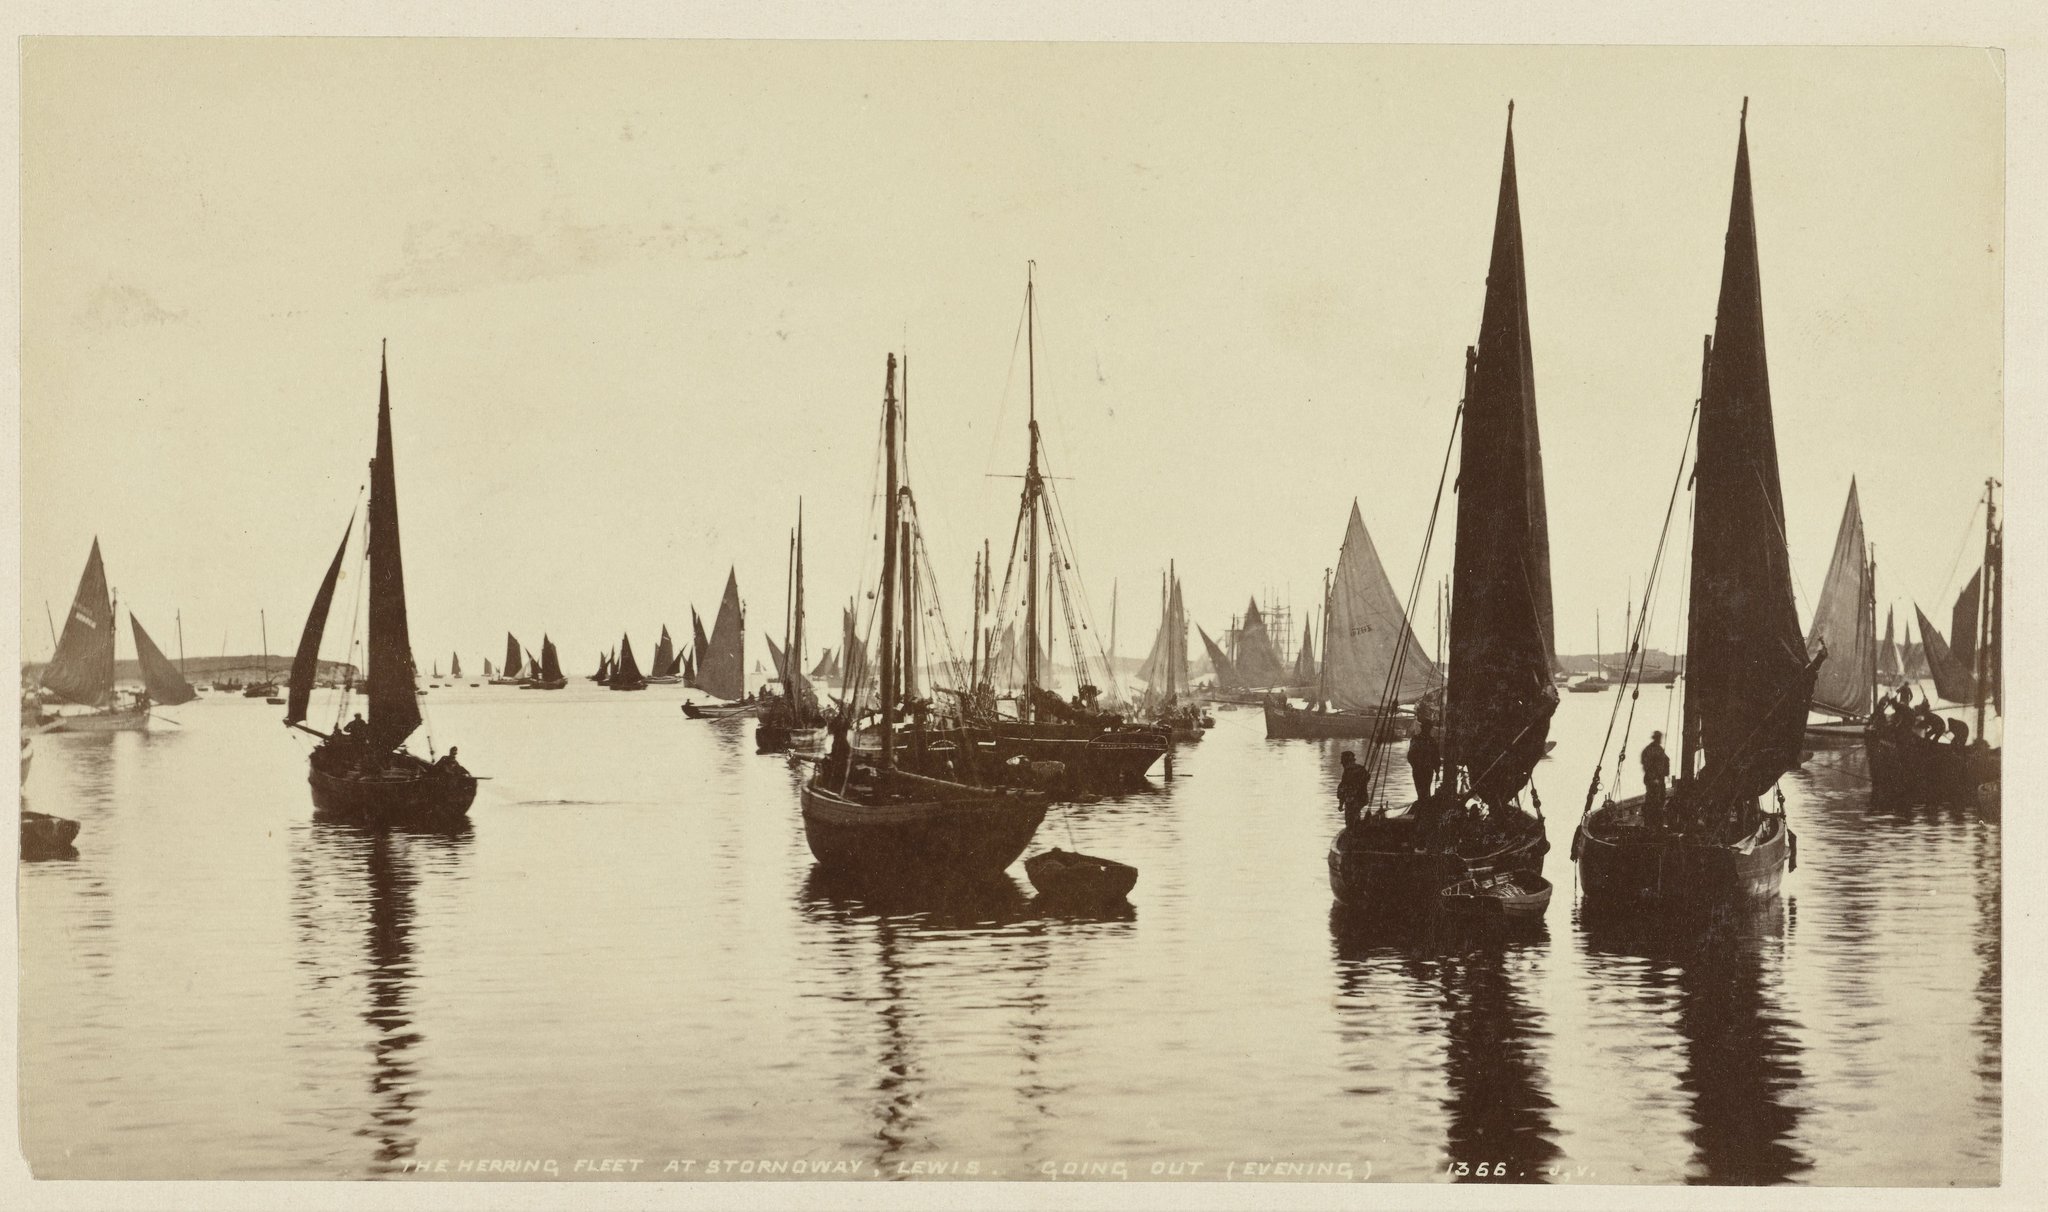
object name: photograph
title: Haringschepen bij Stornoway op Lewis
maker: james valentine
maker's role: fotograaf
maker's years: 1815-1880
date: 1851-1880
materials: cardboard, paper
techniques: albumen print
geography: lewis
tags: ships (in general) - cc - more than one ship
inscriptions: number: ‘1366.’